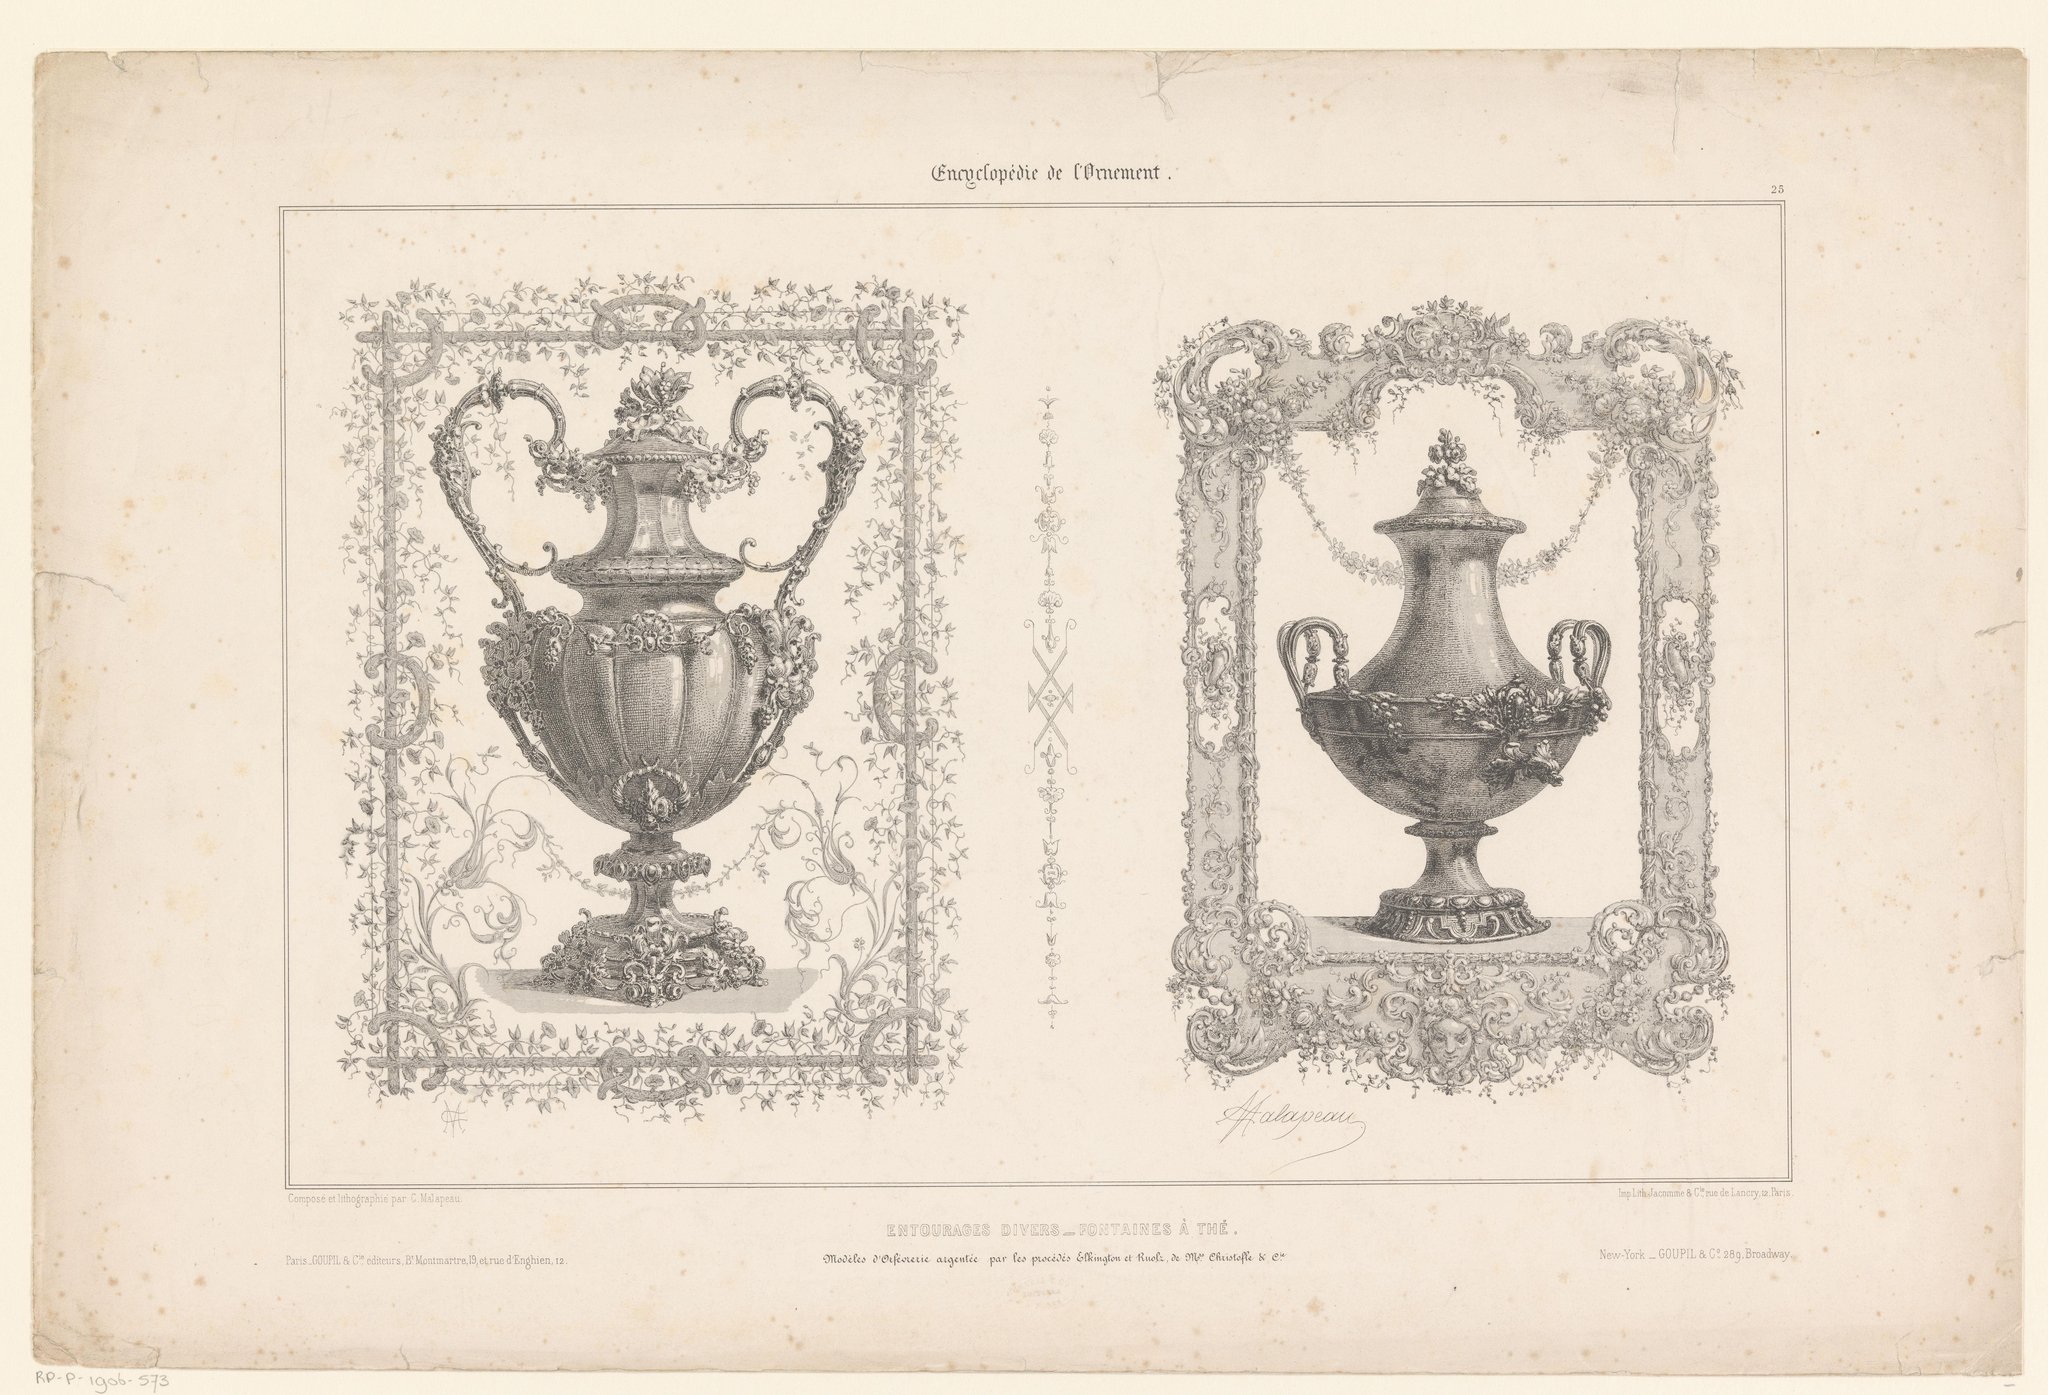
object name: print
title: Twee vazen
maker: claude nicolas malapeau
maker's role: print maker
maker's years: 1755-1803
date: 1850-1860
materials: paper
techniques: lithograph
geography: paris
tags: vase ~ ornament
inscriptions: collector's mark: Lugt 2228, check stamp: ‘Goupil, Vibert & C / Editeurs / A Paris’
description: Twee geornamenteerde vazen met oren en bloemmotieven. Rondom beide vazen een ornamentele omlijsting.